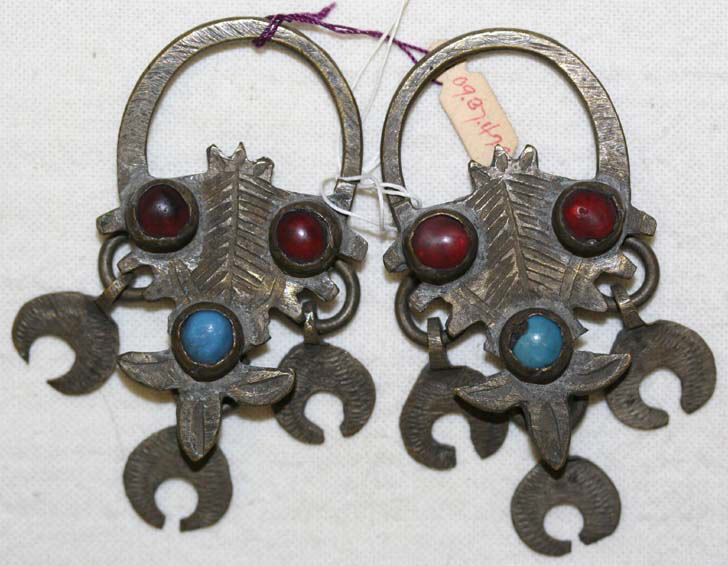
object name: earring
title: Earrings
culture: european, eastern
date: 1701-1900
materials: metal